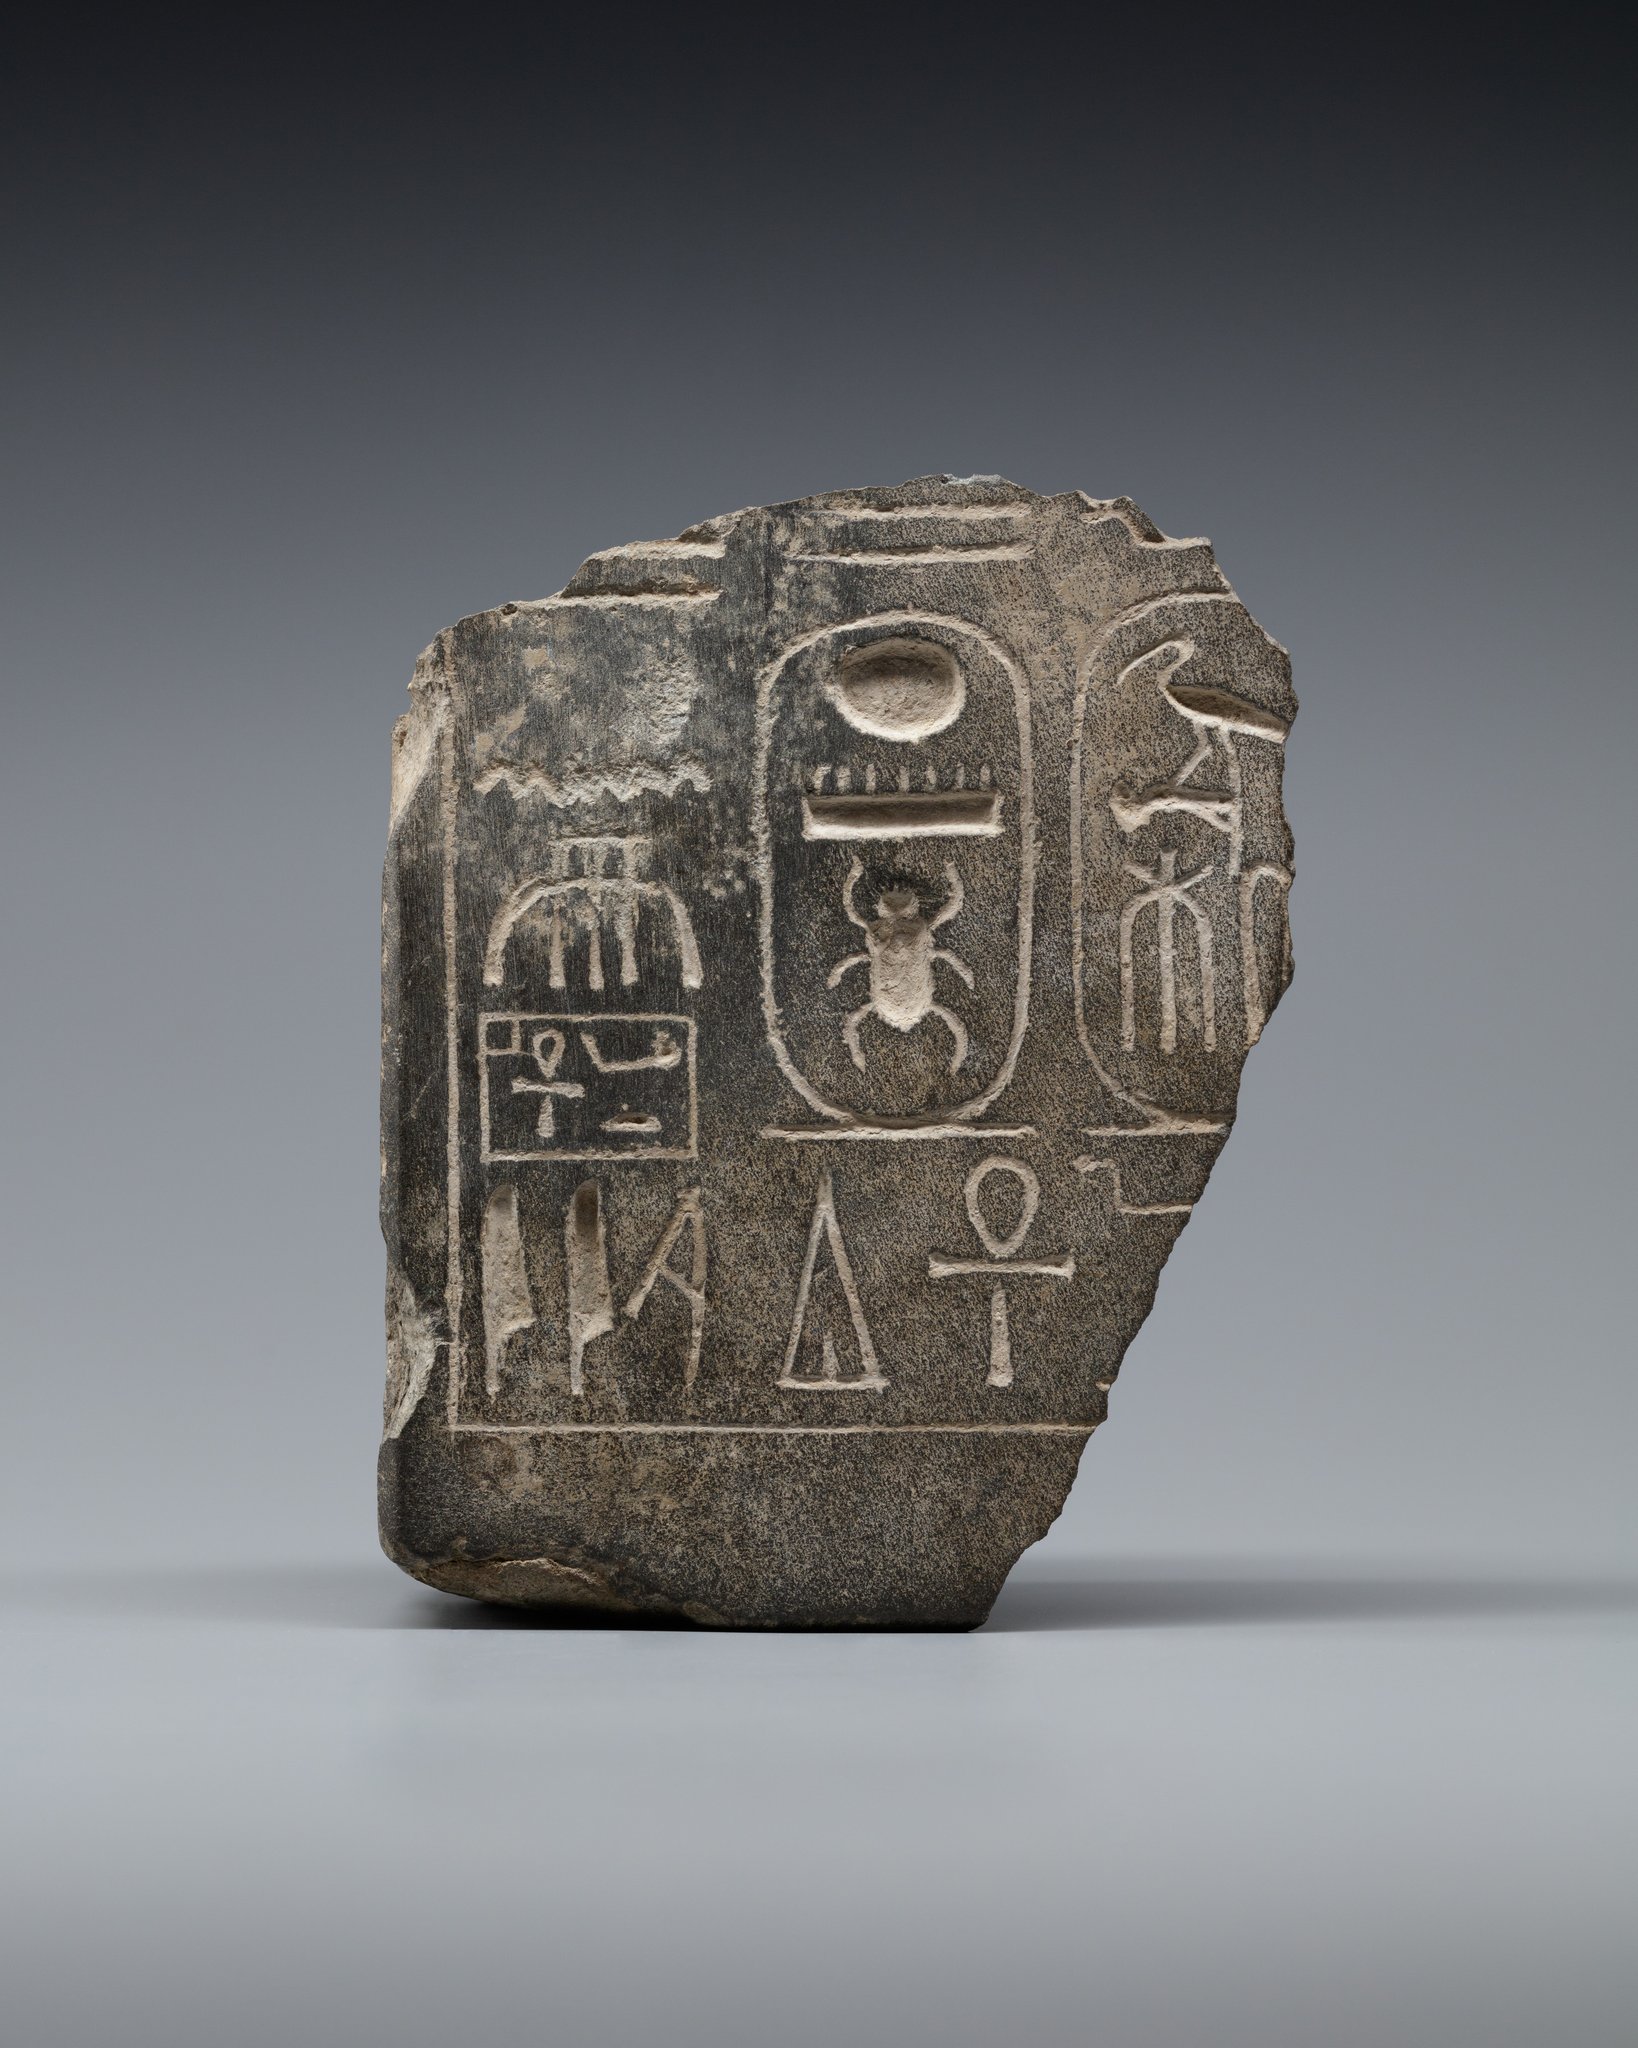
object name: statue throne fragment, thutmose iii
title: Fragment of statue of Thutmose III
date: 1479-1425 BCE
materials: stone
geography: egypt